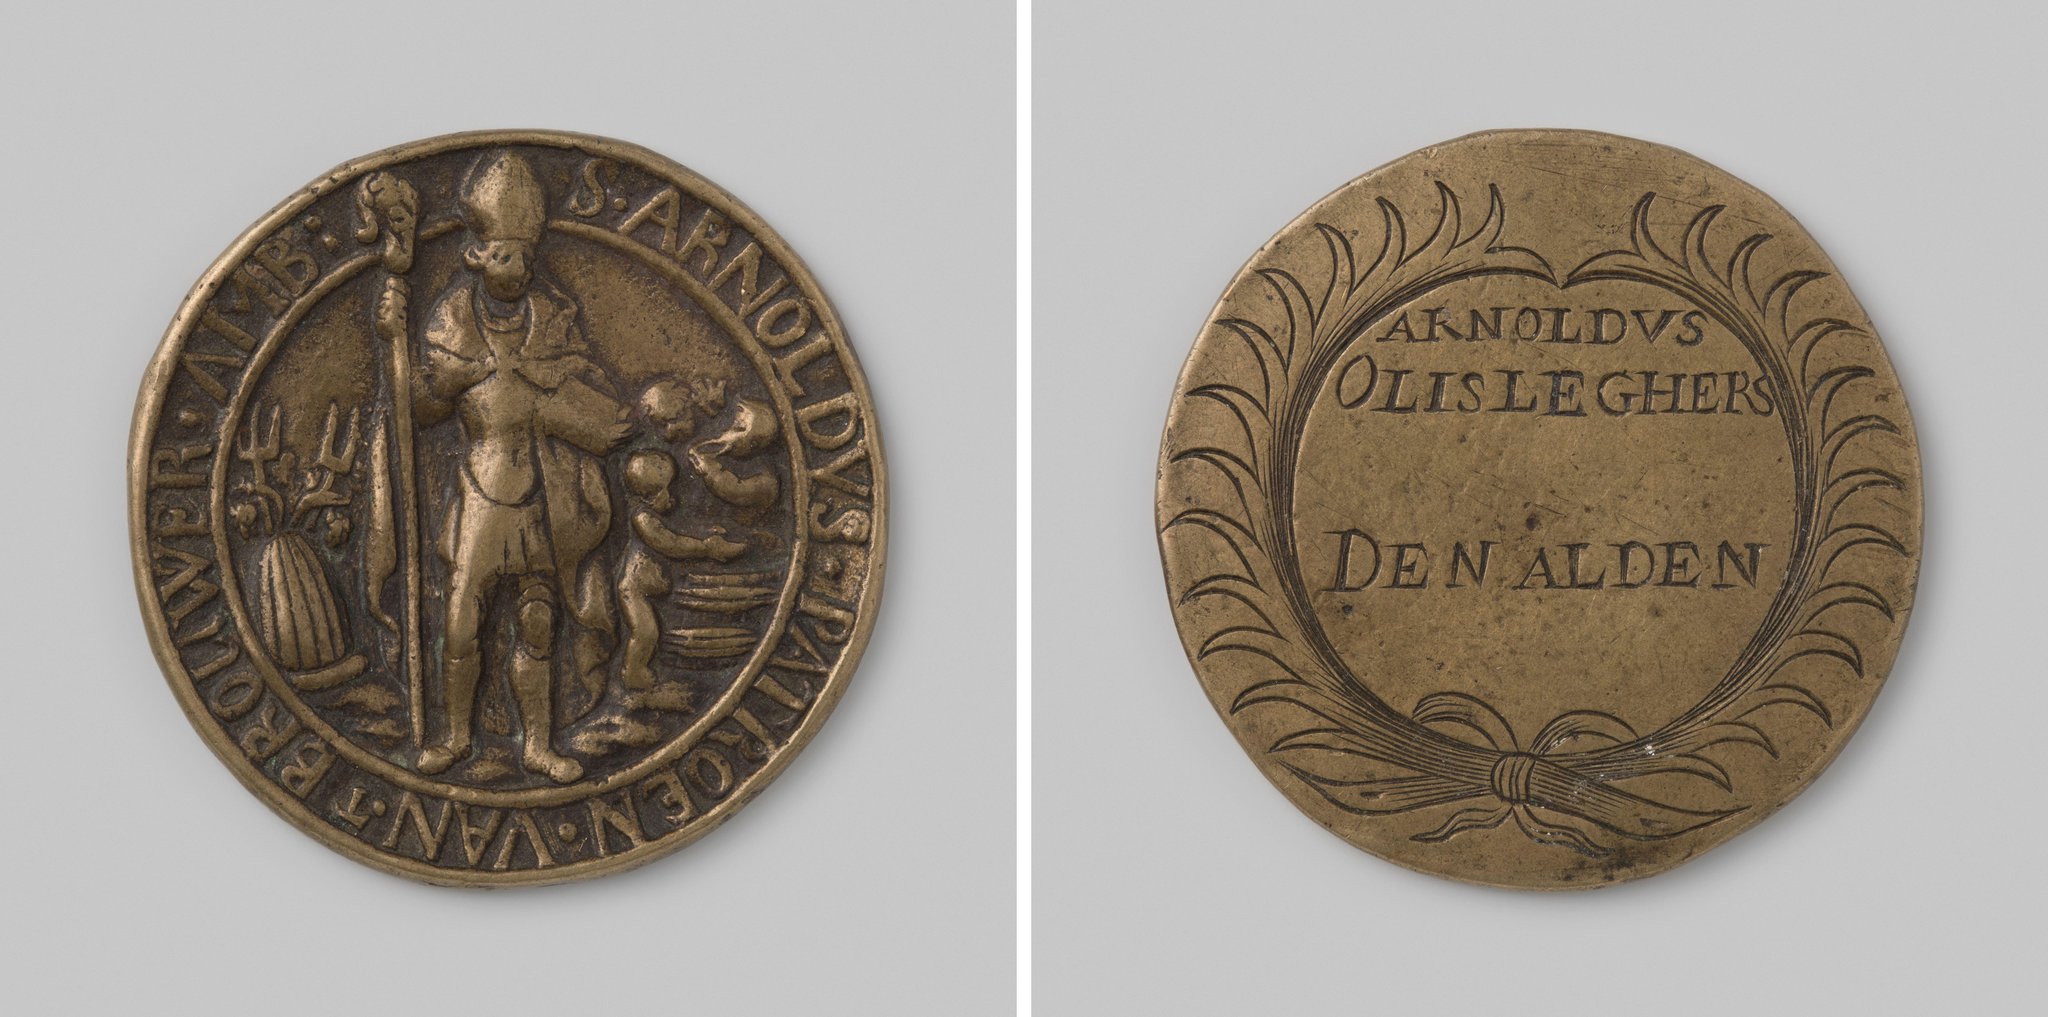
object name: medal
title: Presentiepenning van het Brouwersgilde te Maastricht, 1654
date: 1654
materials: brass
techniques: casting, engraving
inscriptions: circumscription: ‘S ARNOLDVS PATROEN VAN T BROUWER AMB’, inscription: ‘ARNOLDVS / OLISLEGHERS / DEN ALDEN’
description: Gegoten messing penning, op de voorzijde Sint Arnoldus, als bisschop naast drie kinderen rond een ketel, met omschrift, op de gladgemaakte keerzijde gegraveerd drie regels tekst binnen samengebonden lauwertakken, op naam van Arnoldus Olisleghers den Alden